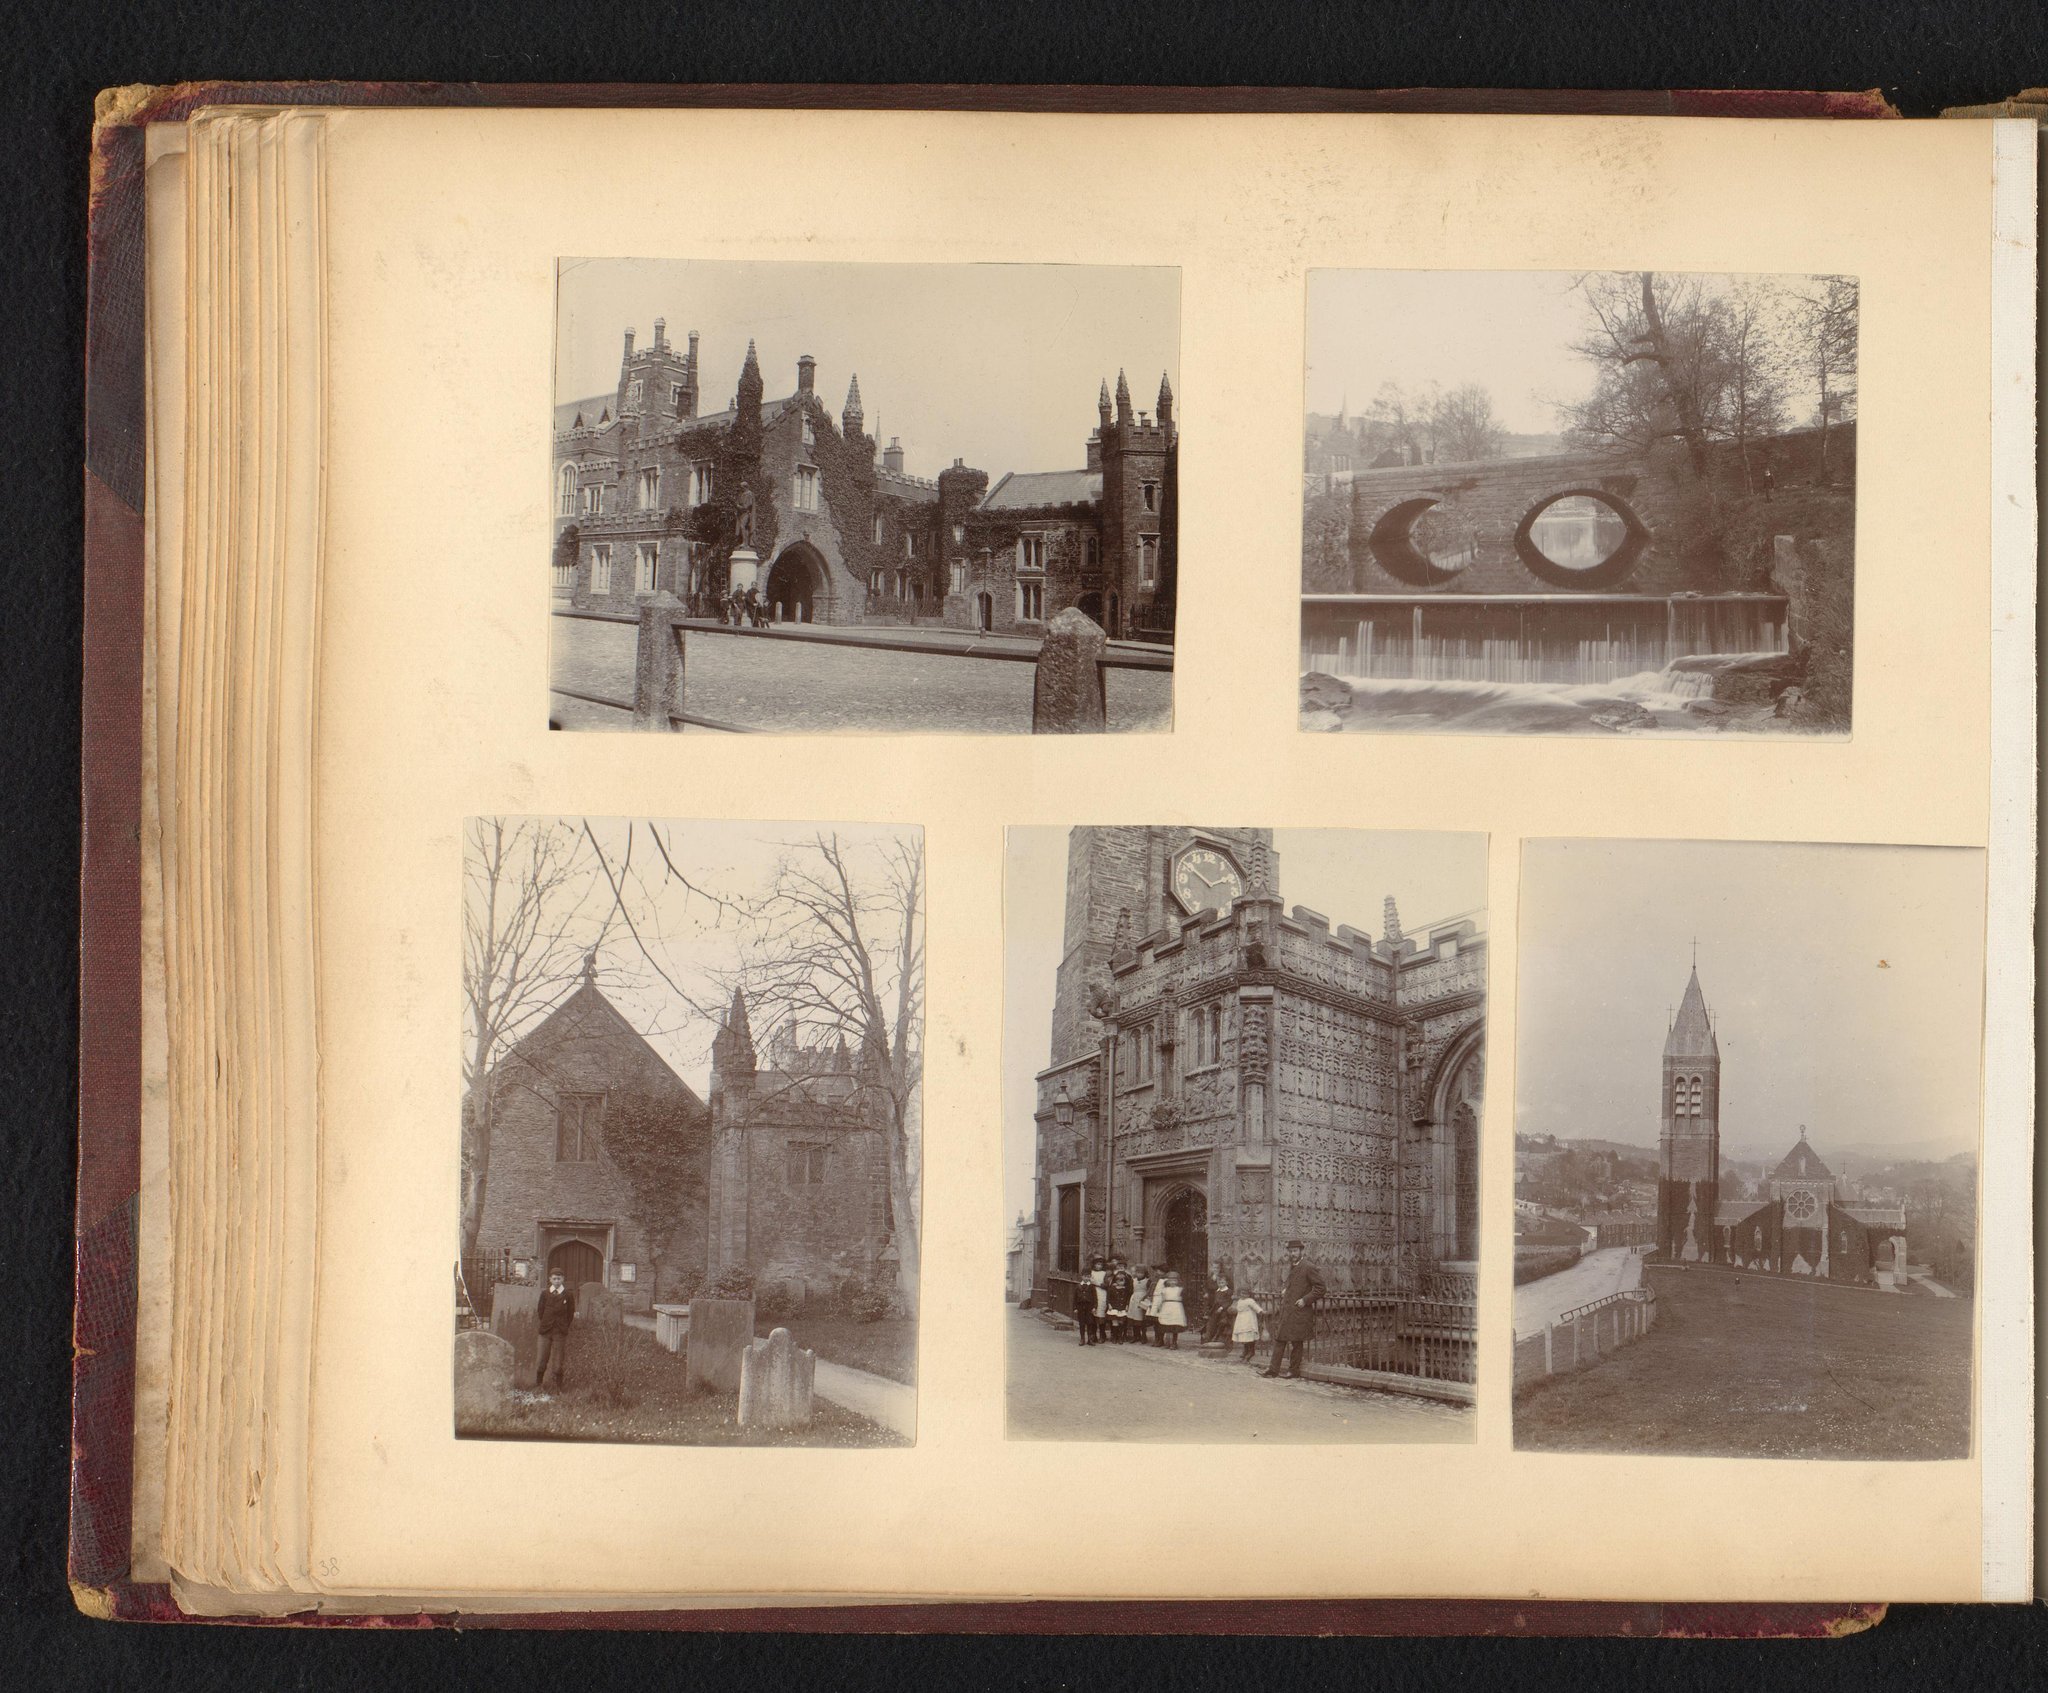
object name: photograph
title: Diverse onderwerpen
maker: Anonymous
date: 1890-1898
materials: photographic support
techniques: daylight paper print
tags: historical persons, church (exterior), bridge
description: Portretten voor gebouwen, onder meer een kerk en gezichten op een brug en een kerk. Deze pagina maakt deel uit van een album.